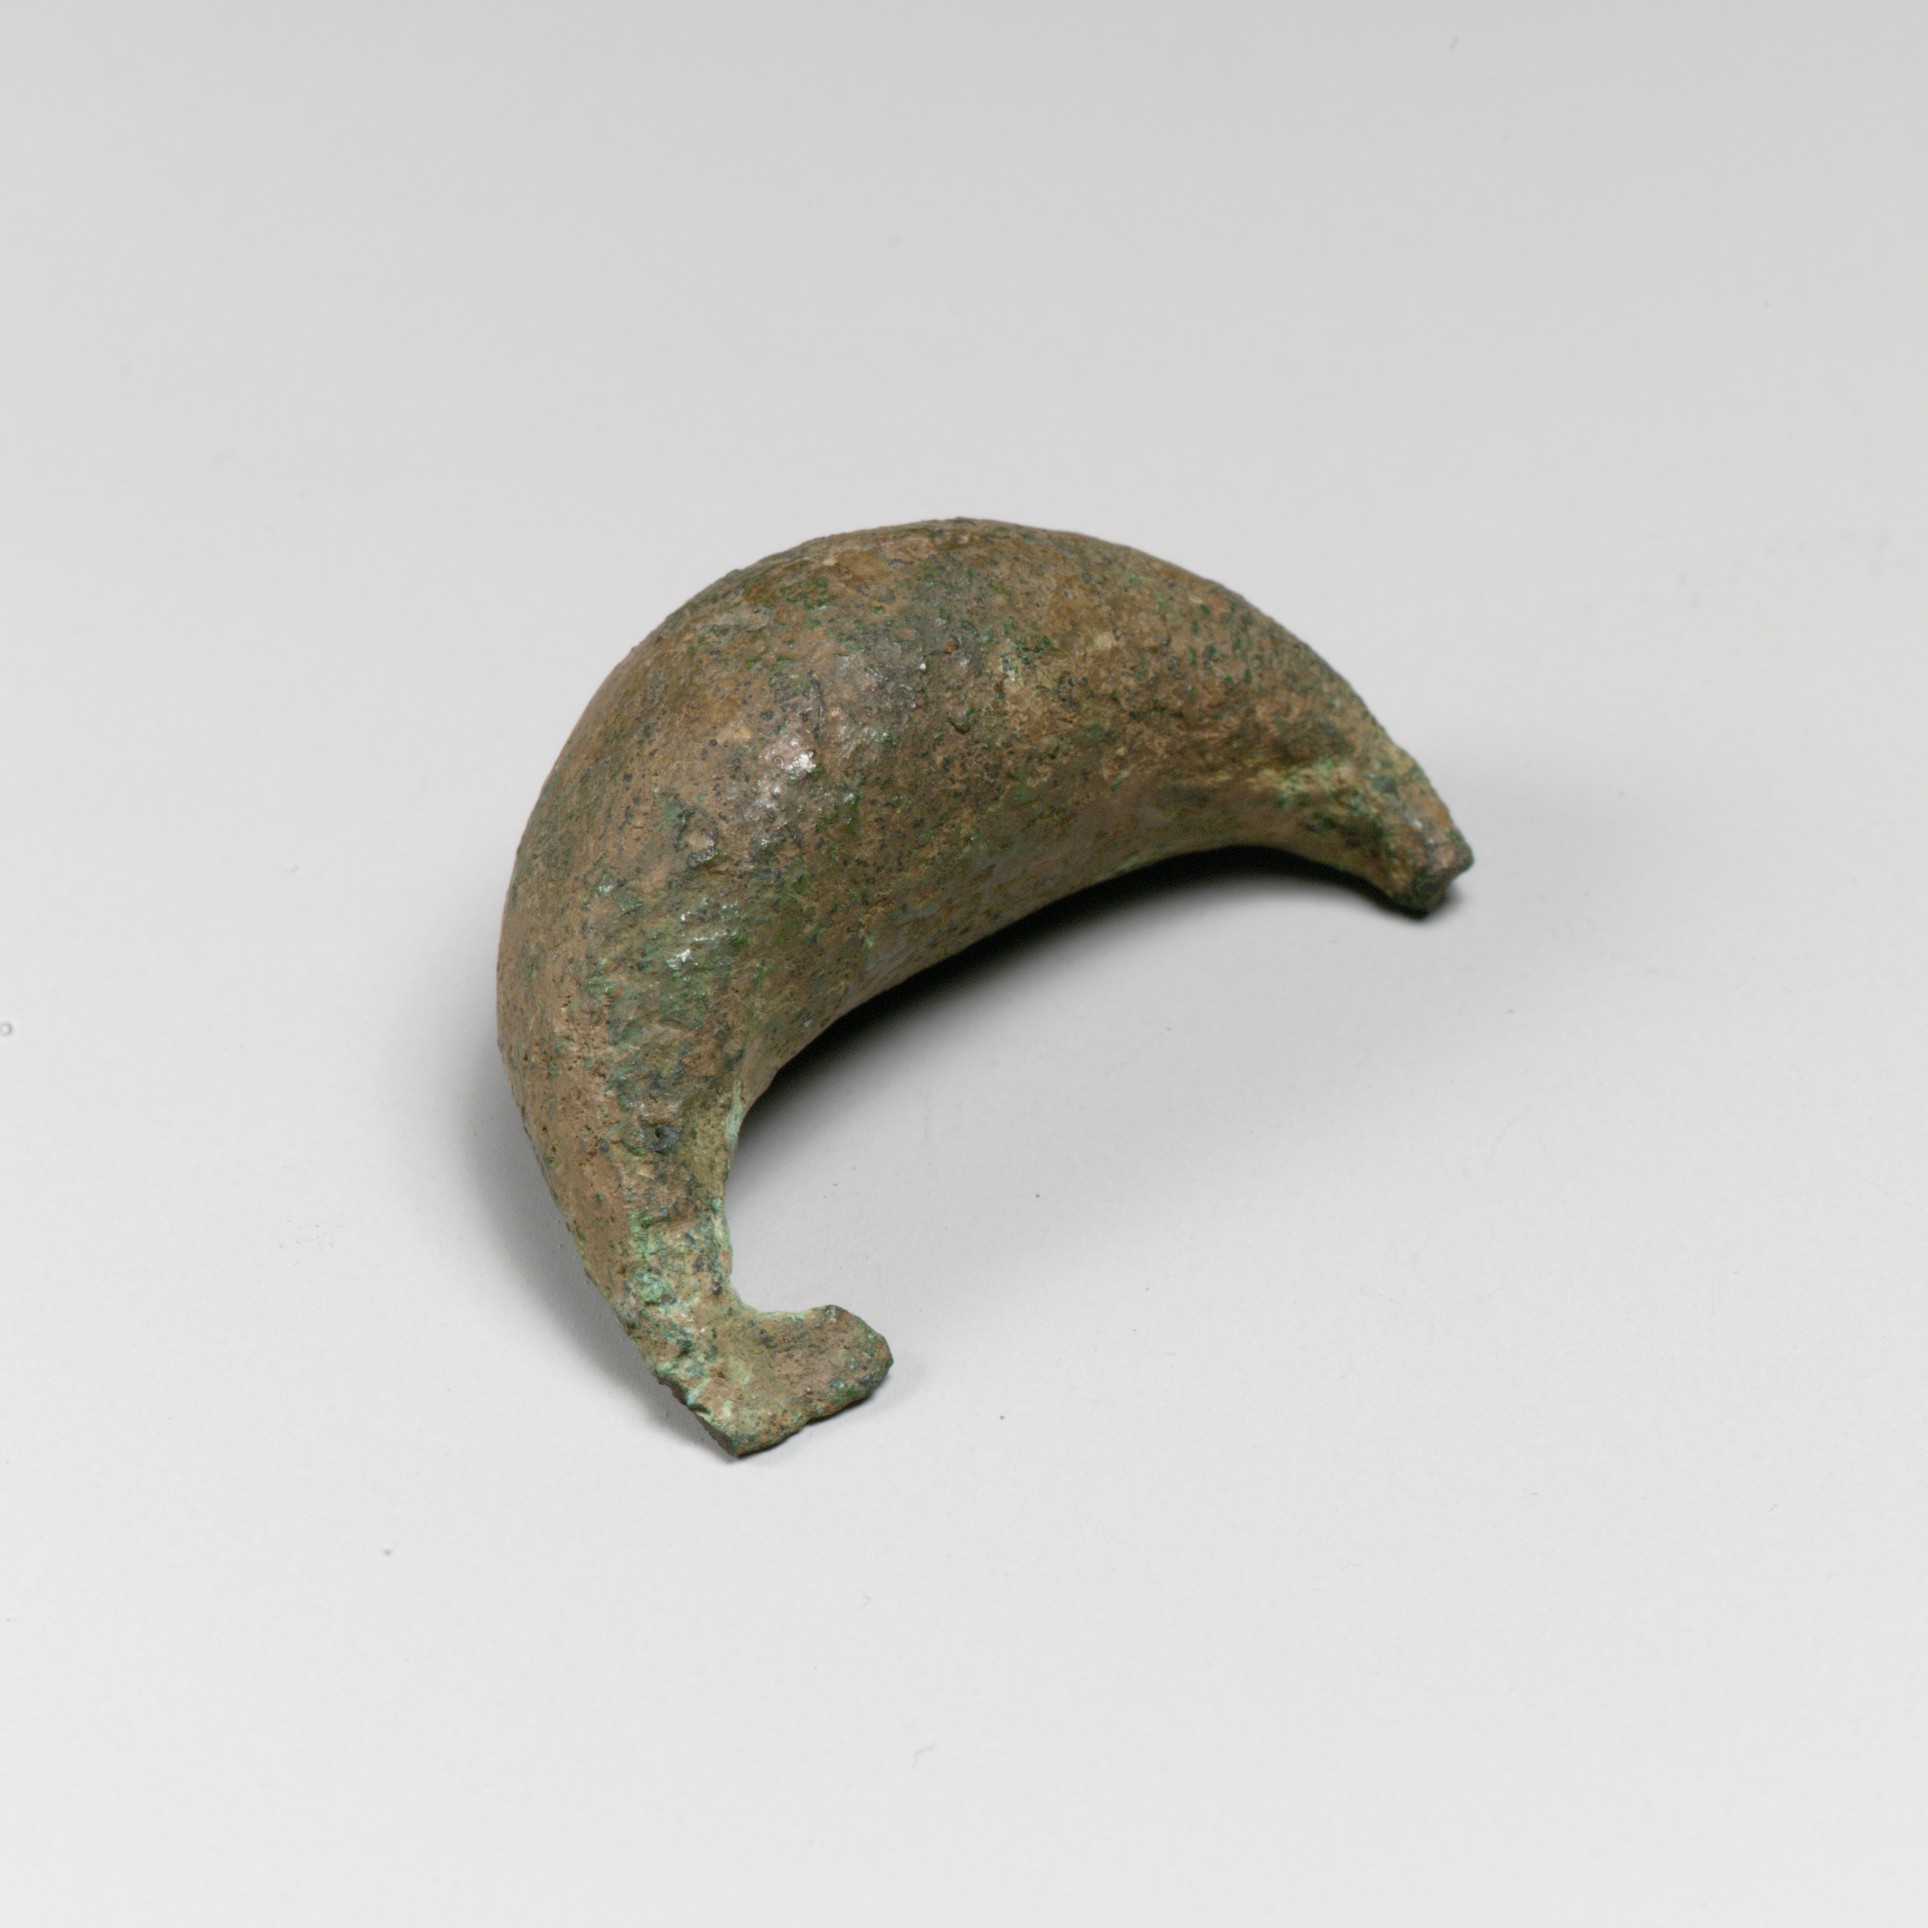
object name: fibula, boat shaped type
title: Fibula, boat-shaped type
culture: italic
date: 800-501 BCE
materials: bronze